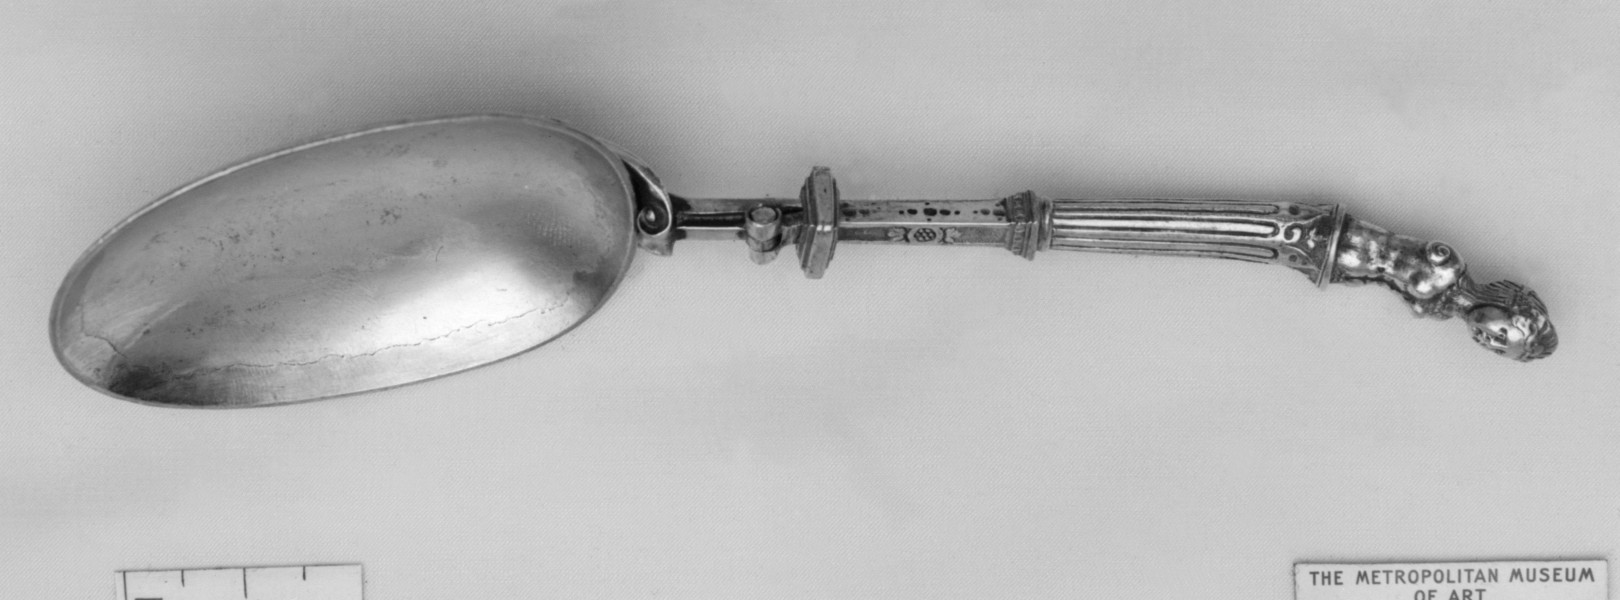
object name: spoon and fork combination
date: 1601-1633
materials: gilt, silver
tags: female nudes